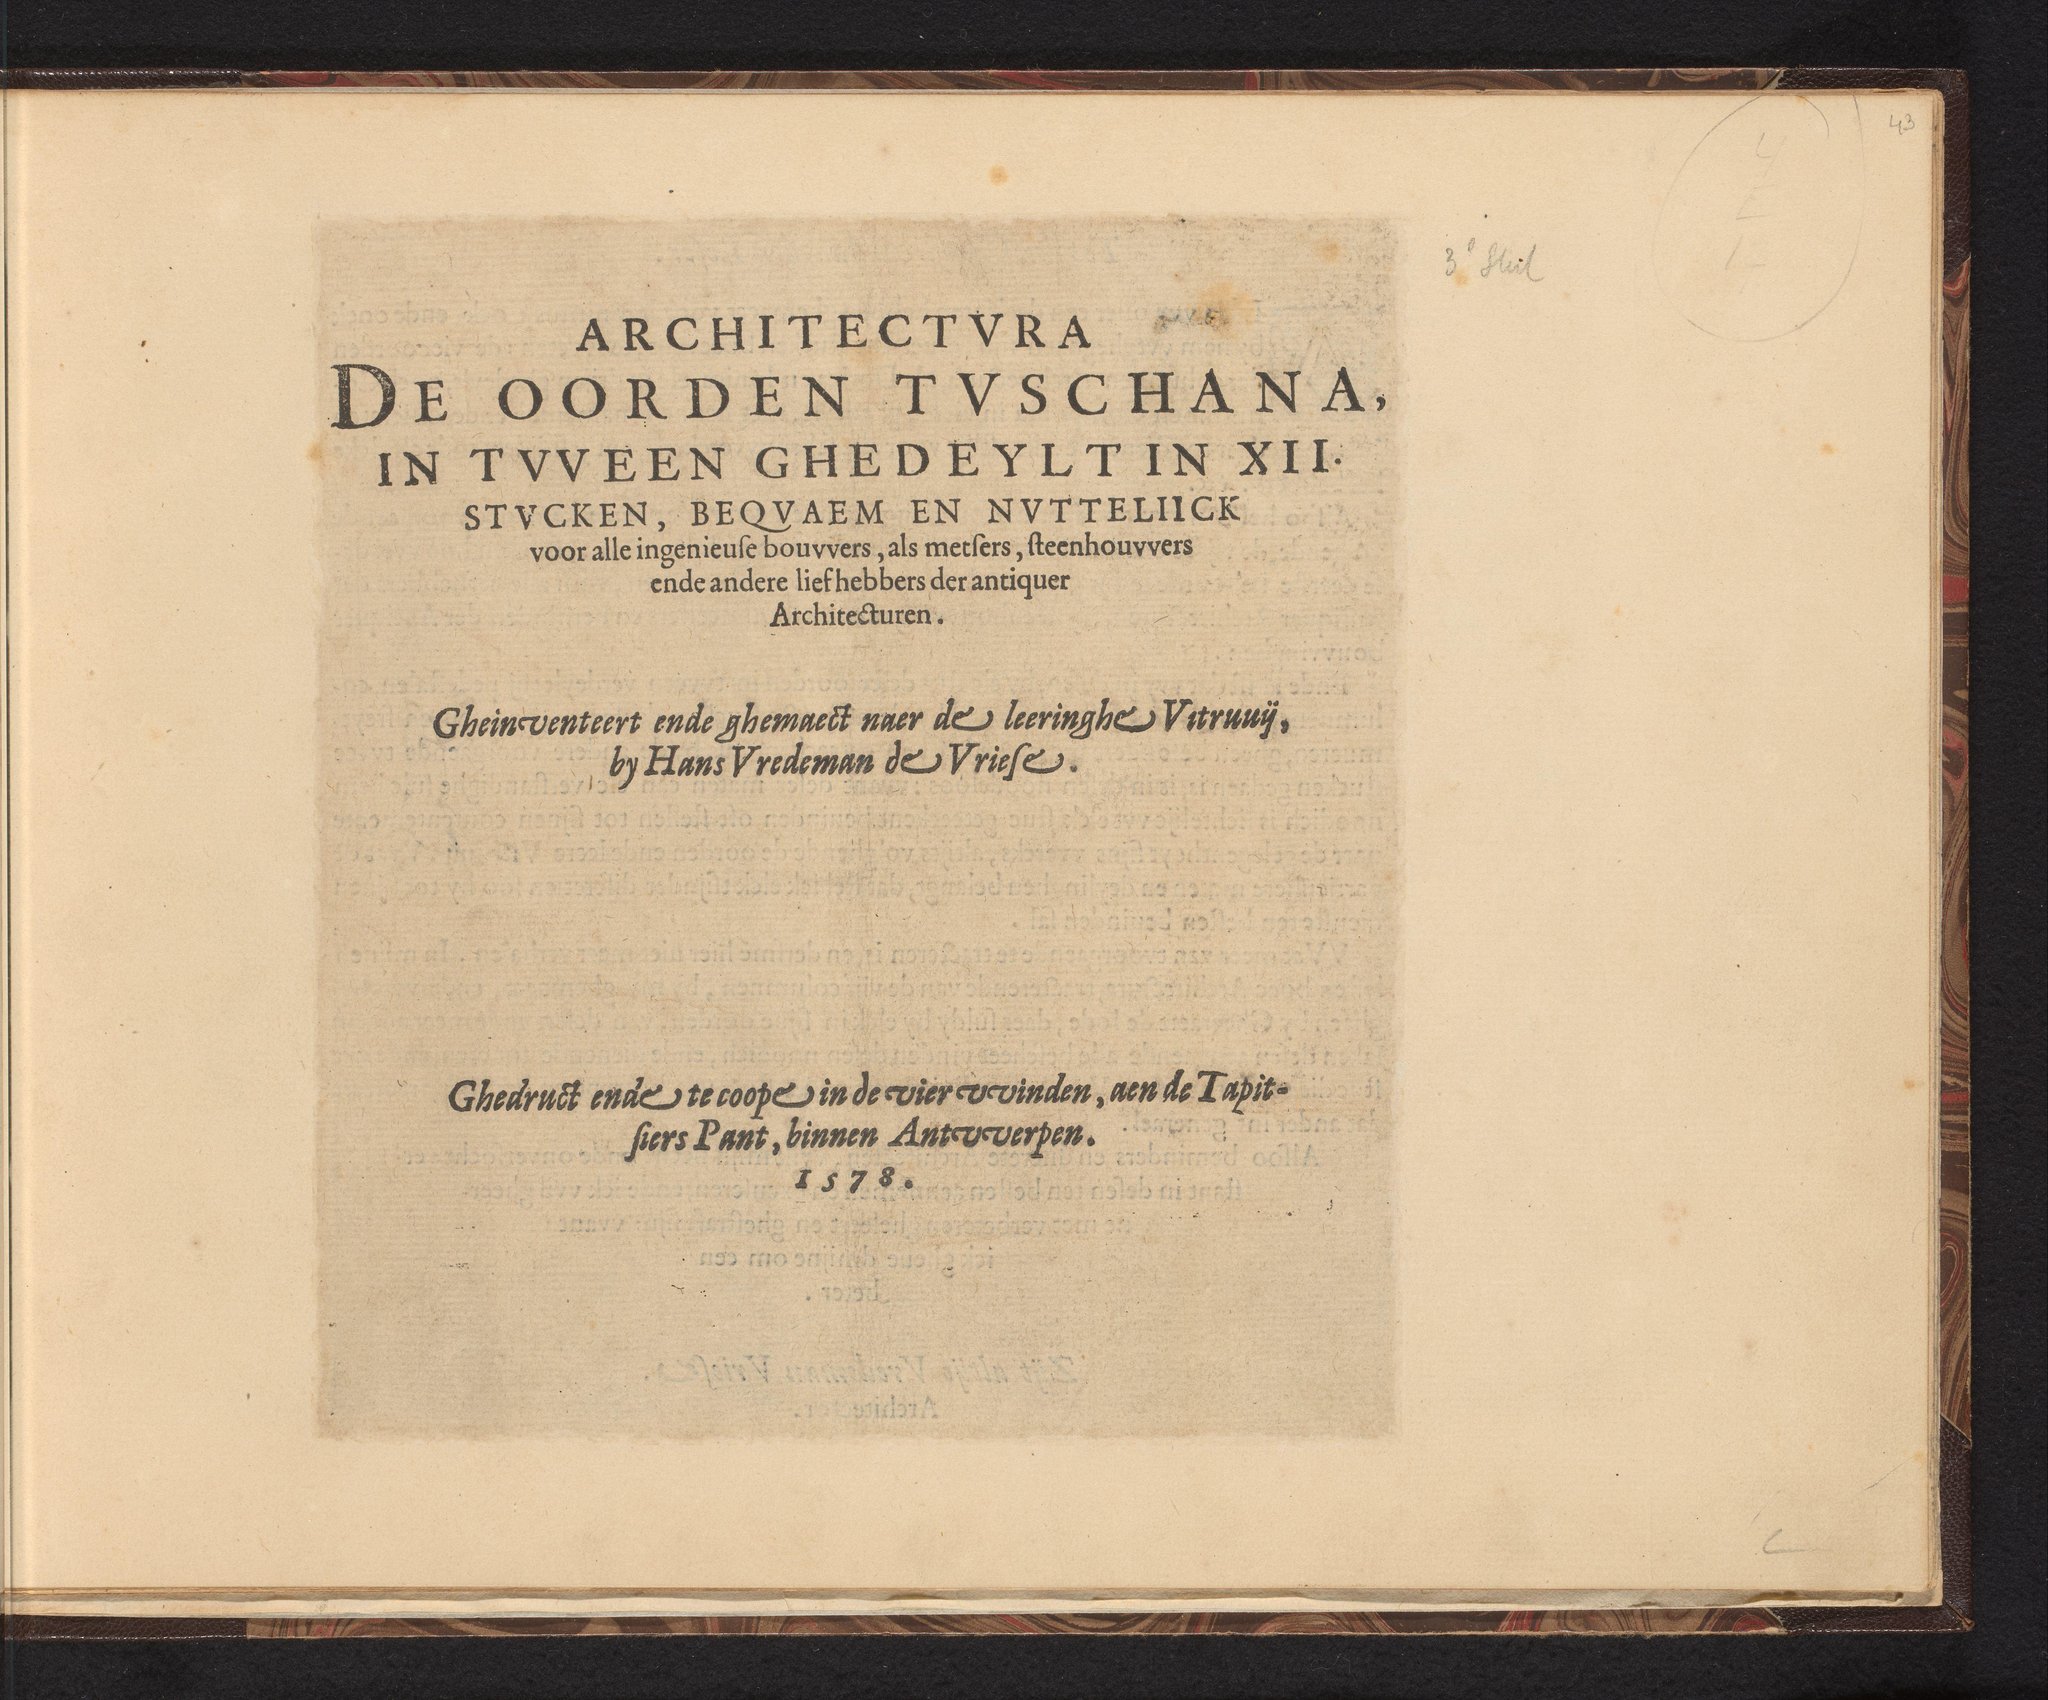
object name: text sheet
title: Titelpagina voor: Architectura de Oorden Tuschana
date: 1578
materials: paper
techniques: letterpress printing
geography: antwerp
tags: title-page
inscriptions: date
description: Titelpagina voor de serie: Architectura de Oorden Tusschana, in tween ghedeylt in XII. stucken ... Volgens de tekst is de serie bedoeld voor alle bouwmeesters, metselaars, steenhouwers en liefhebbers van de oude architectuur. Het blad maakt deel uit van een album.